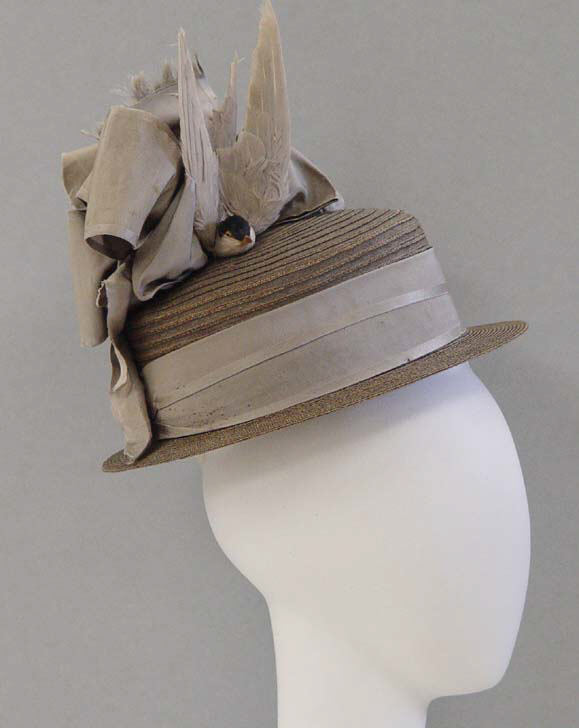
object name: hat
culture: american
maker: h. o'neill & co.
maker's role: designer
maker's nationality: american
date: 1900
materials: silk, fiber